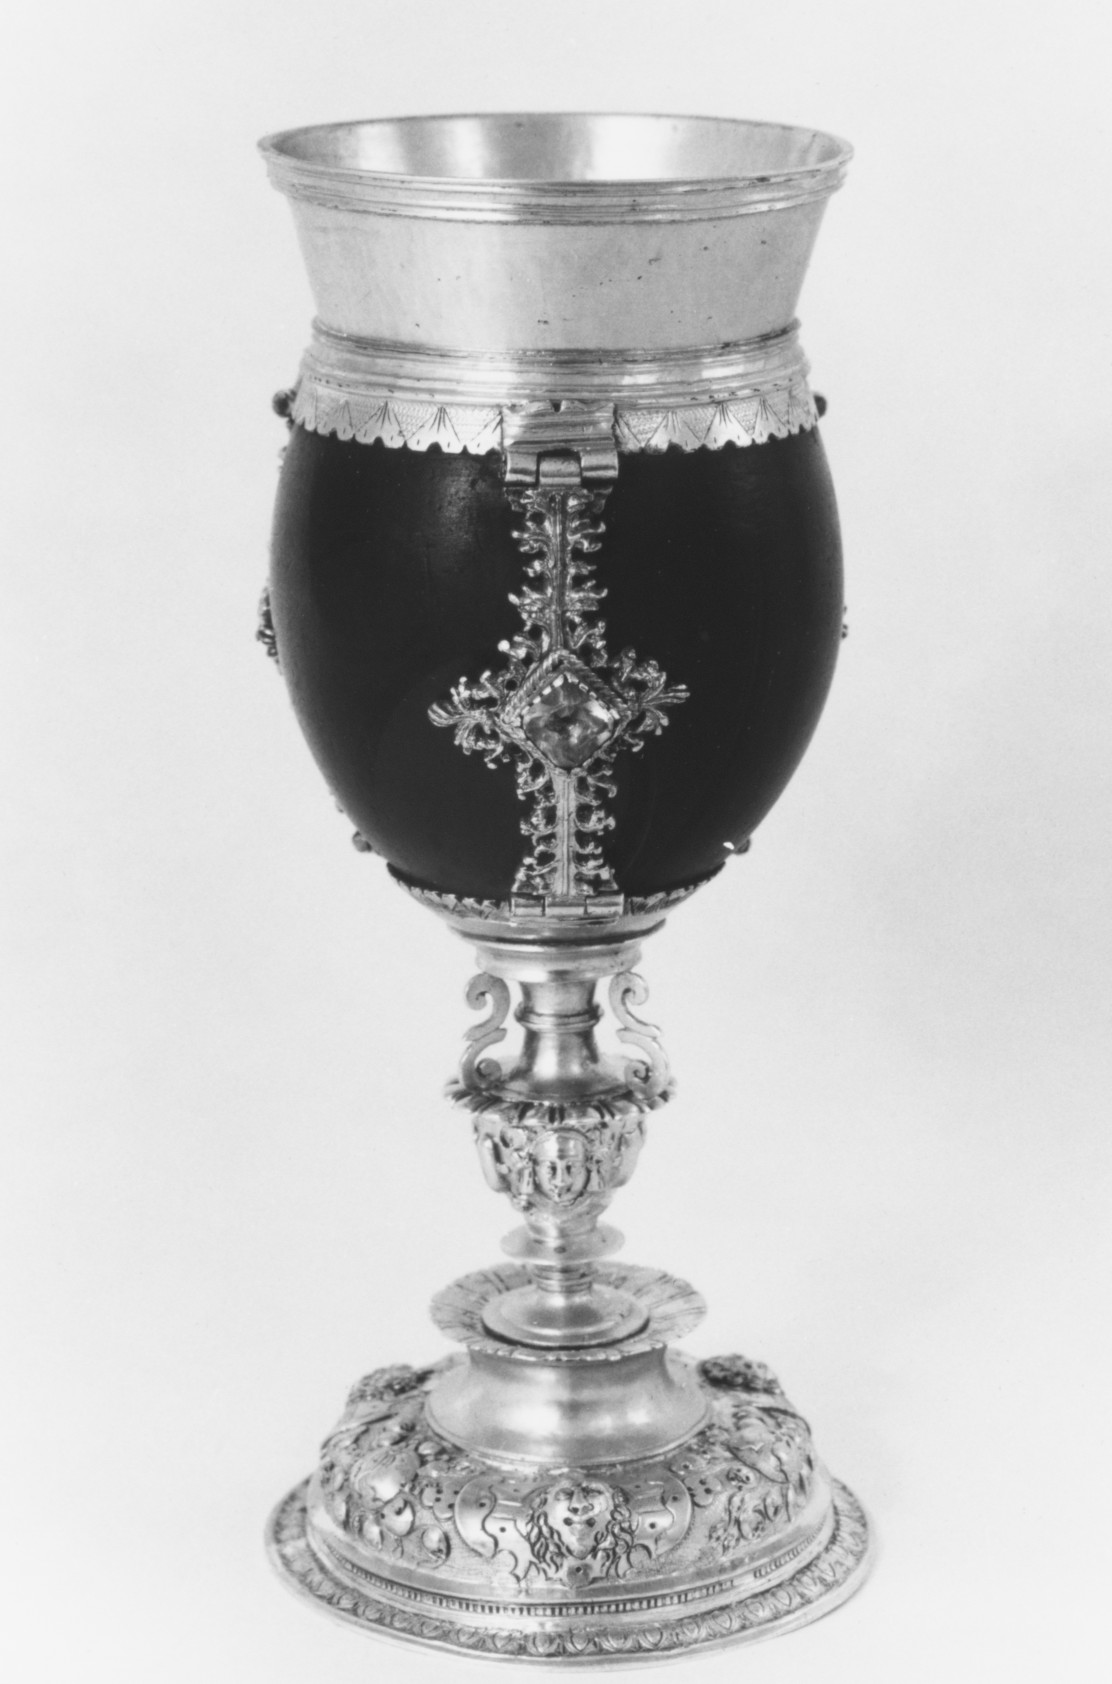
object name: cup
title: Coconut cup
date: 1500-1580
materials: silver gilt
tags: faces